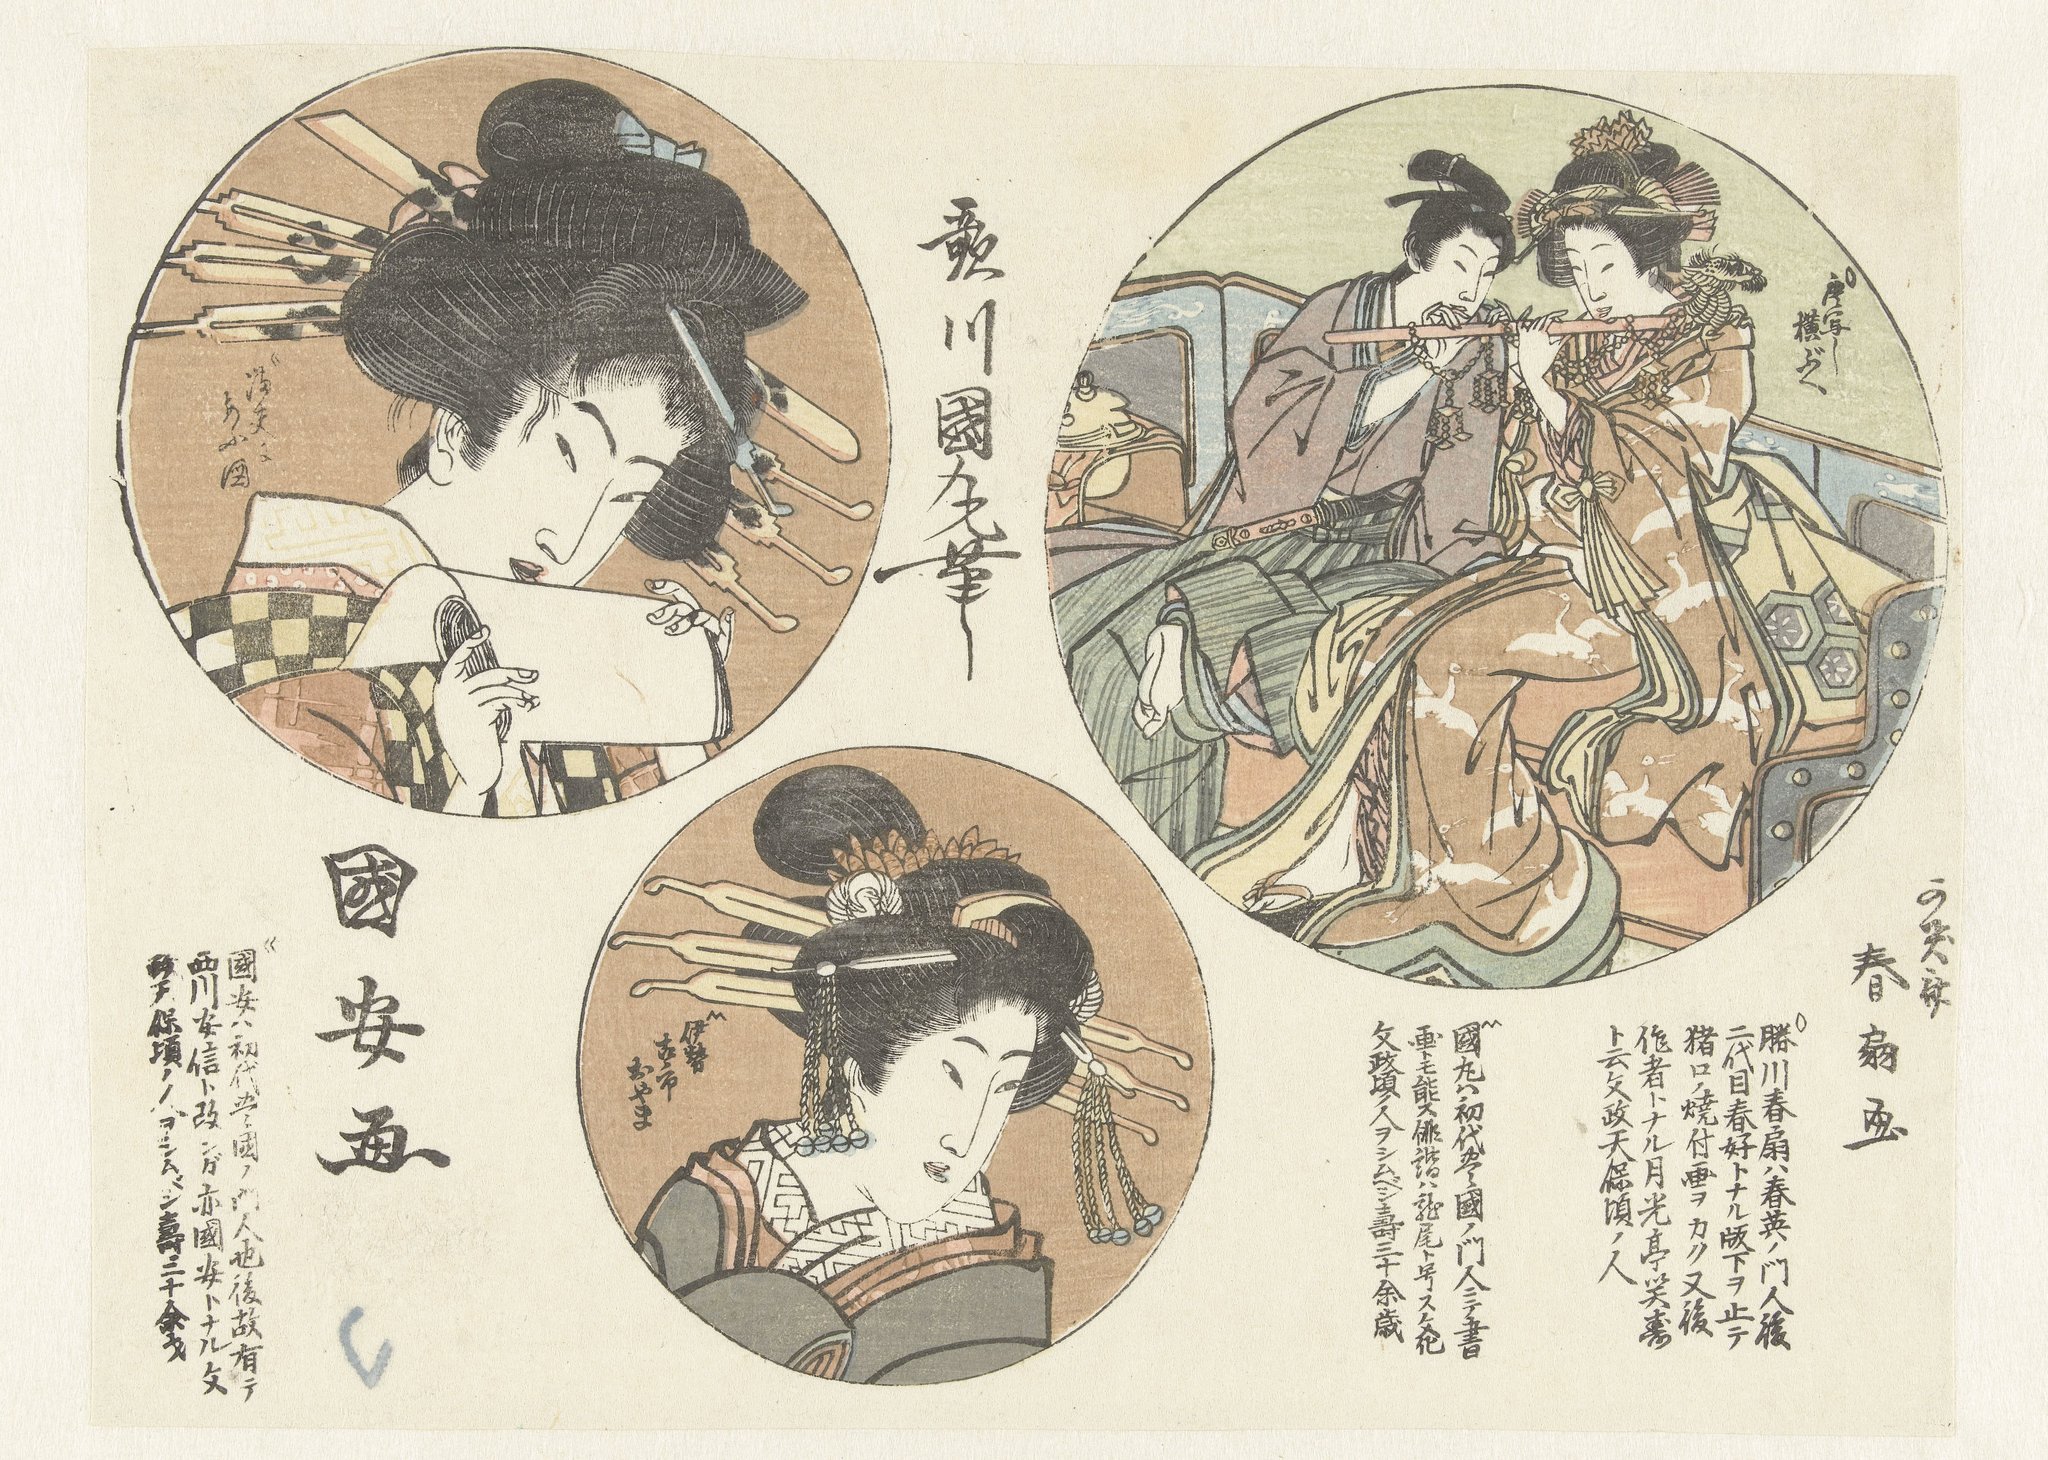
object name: print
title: Vrouwenportretten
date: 1820-1830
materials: paper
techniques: woodcut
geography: japan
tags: adult woman, wind instruments, paper (writing material)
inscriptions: collector's mark: Lugt 2228